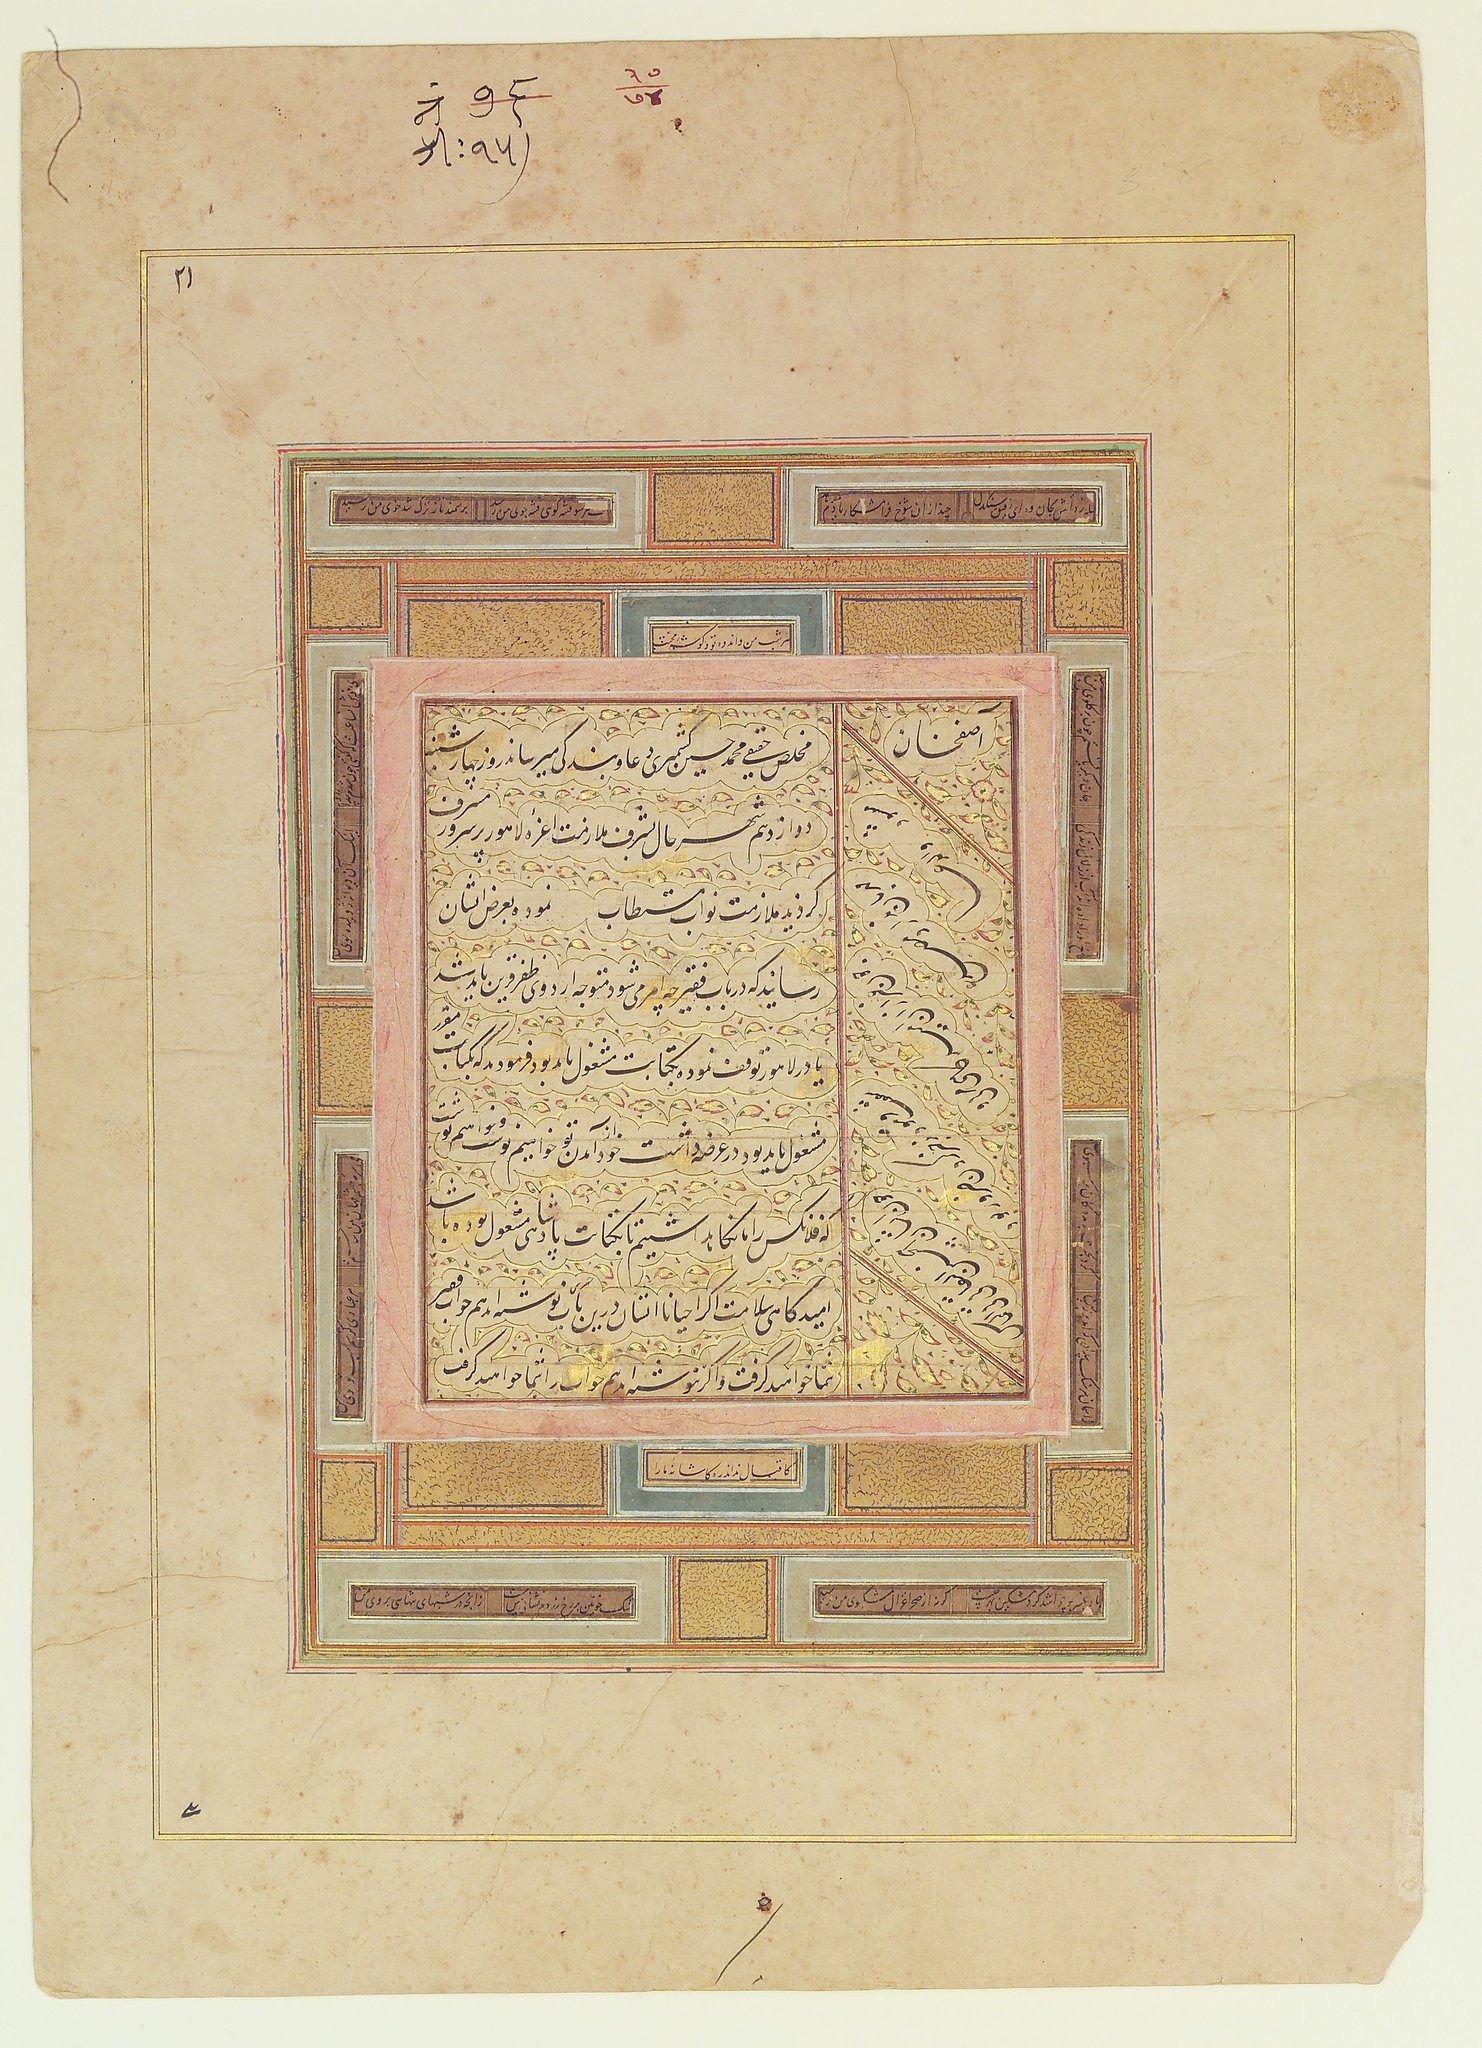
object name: non illustrated single work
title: Page of Calligraphy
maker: muhammad husain kashmiri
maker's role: calligrapher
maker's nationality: indian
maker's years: 1535-1635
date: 1601-1633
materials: gold, ink, paper, watercolor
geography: india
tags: calligraphy